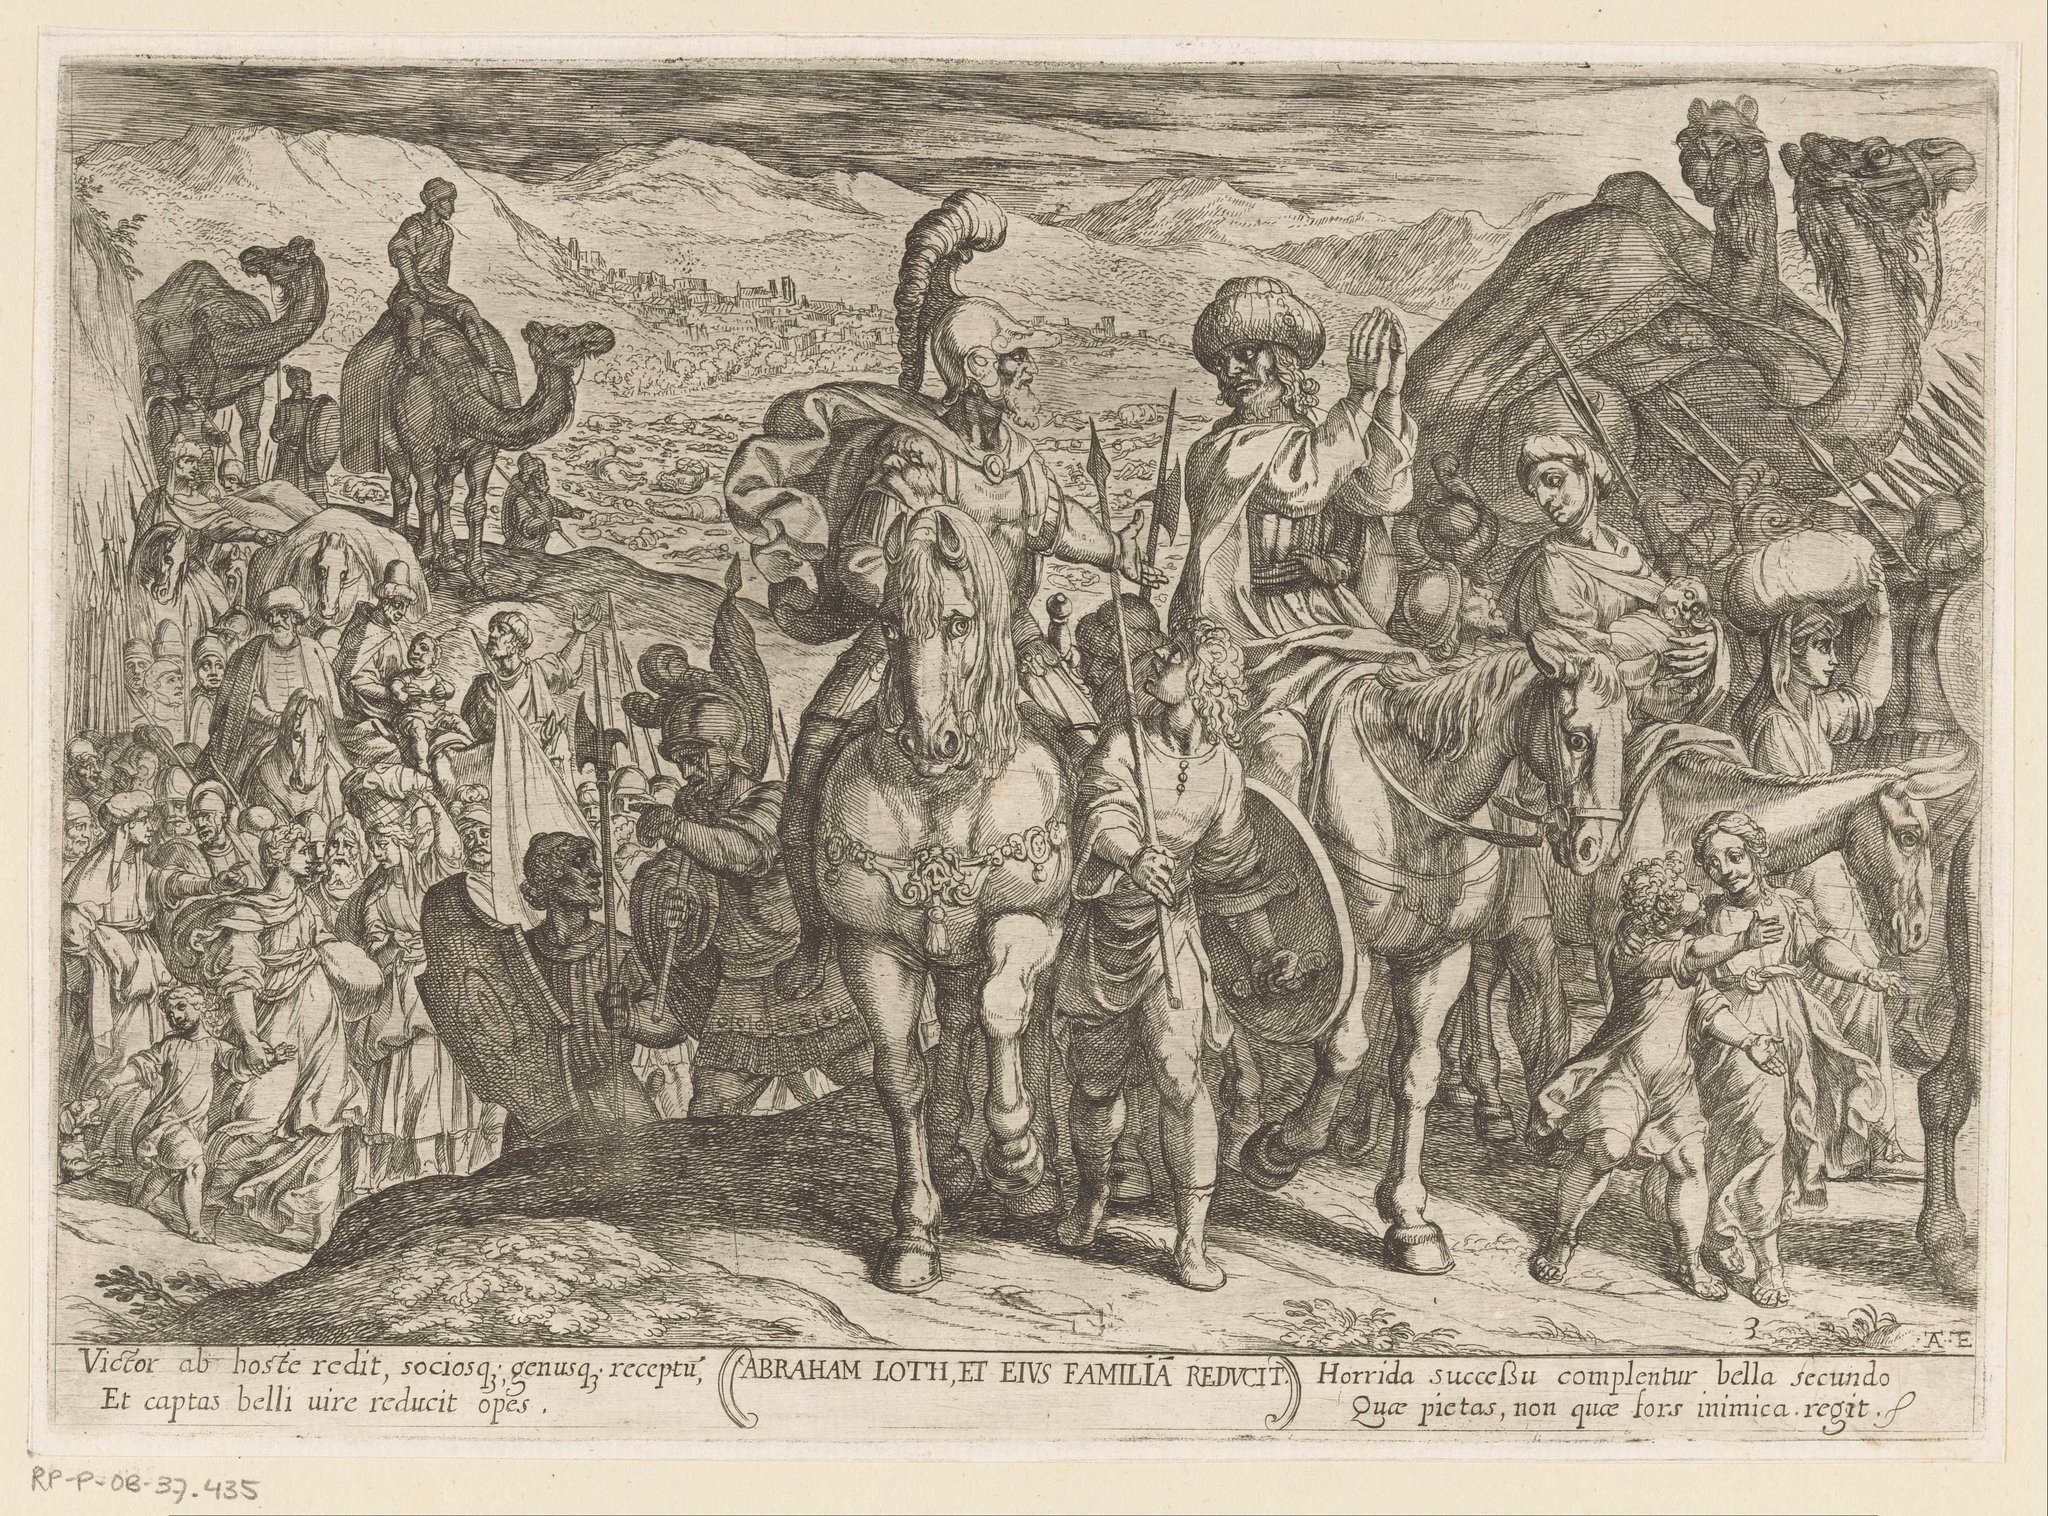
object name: print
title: Abraham Loth, et familia reducit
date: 1613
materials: paper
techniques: etching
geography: rome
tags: abraham liberates lot, recovers the stolen goods and returns in triumph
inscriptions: collector's mark: Lugt 240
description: Abraham en zijn leger brengen Lot en zijn bezittingen en vrouwen terug naar hun land. Titel en onderschrift in het Latijn in de ondermarge.